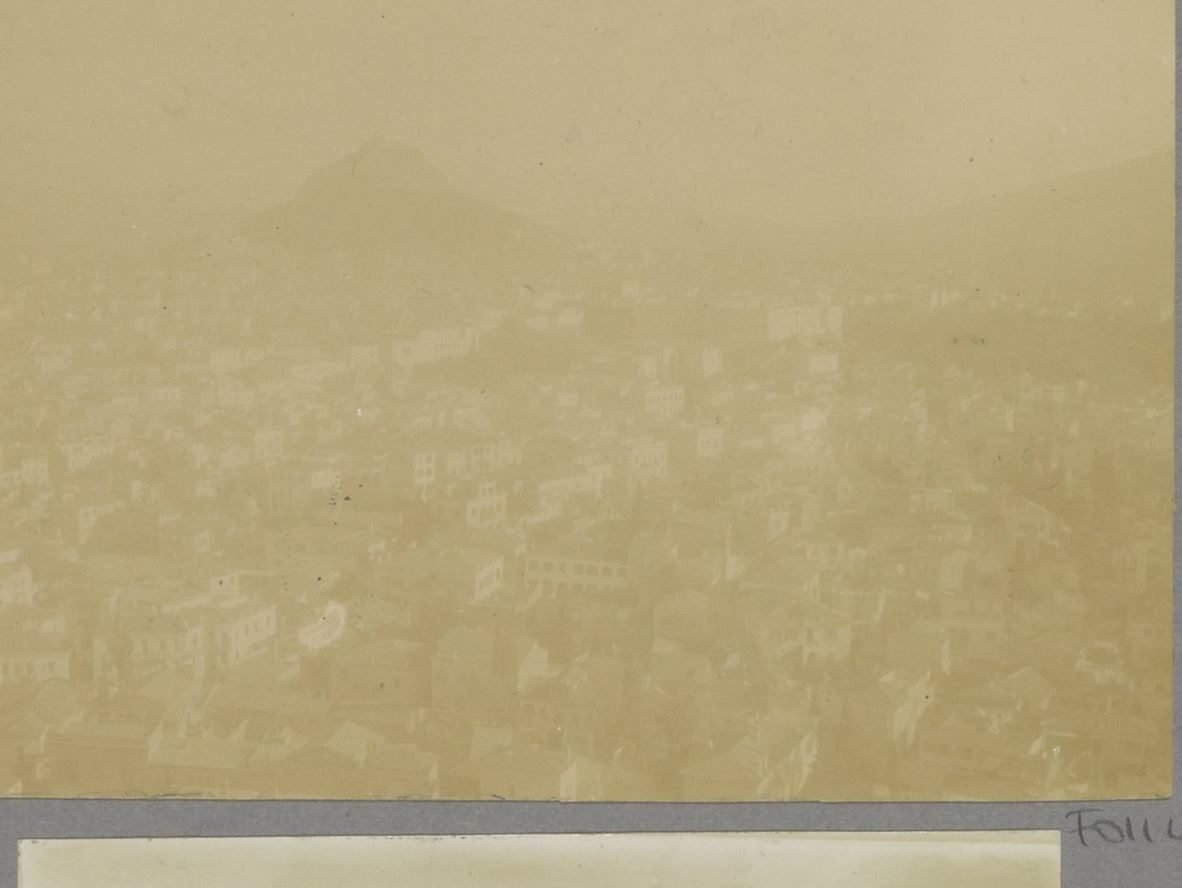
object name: photograph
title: Gezicht op Athene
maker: Anonymous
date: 1905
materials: paper, photographic support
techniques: gelatin silver print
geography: athens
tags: prospect of city, town panorama, silhouette of city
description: Onderdeel van Reisalbum met foto's van bezienswaardigheden in Griekenland en Egypte.